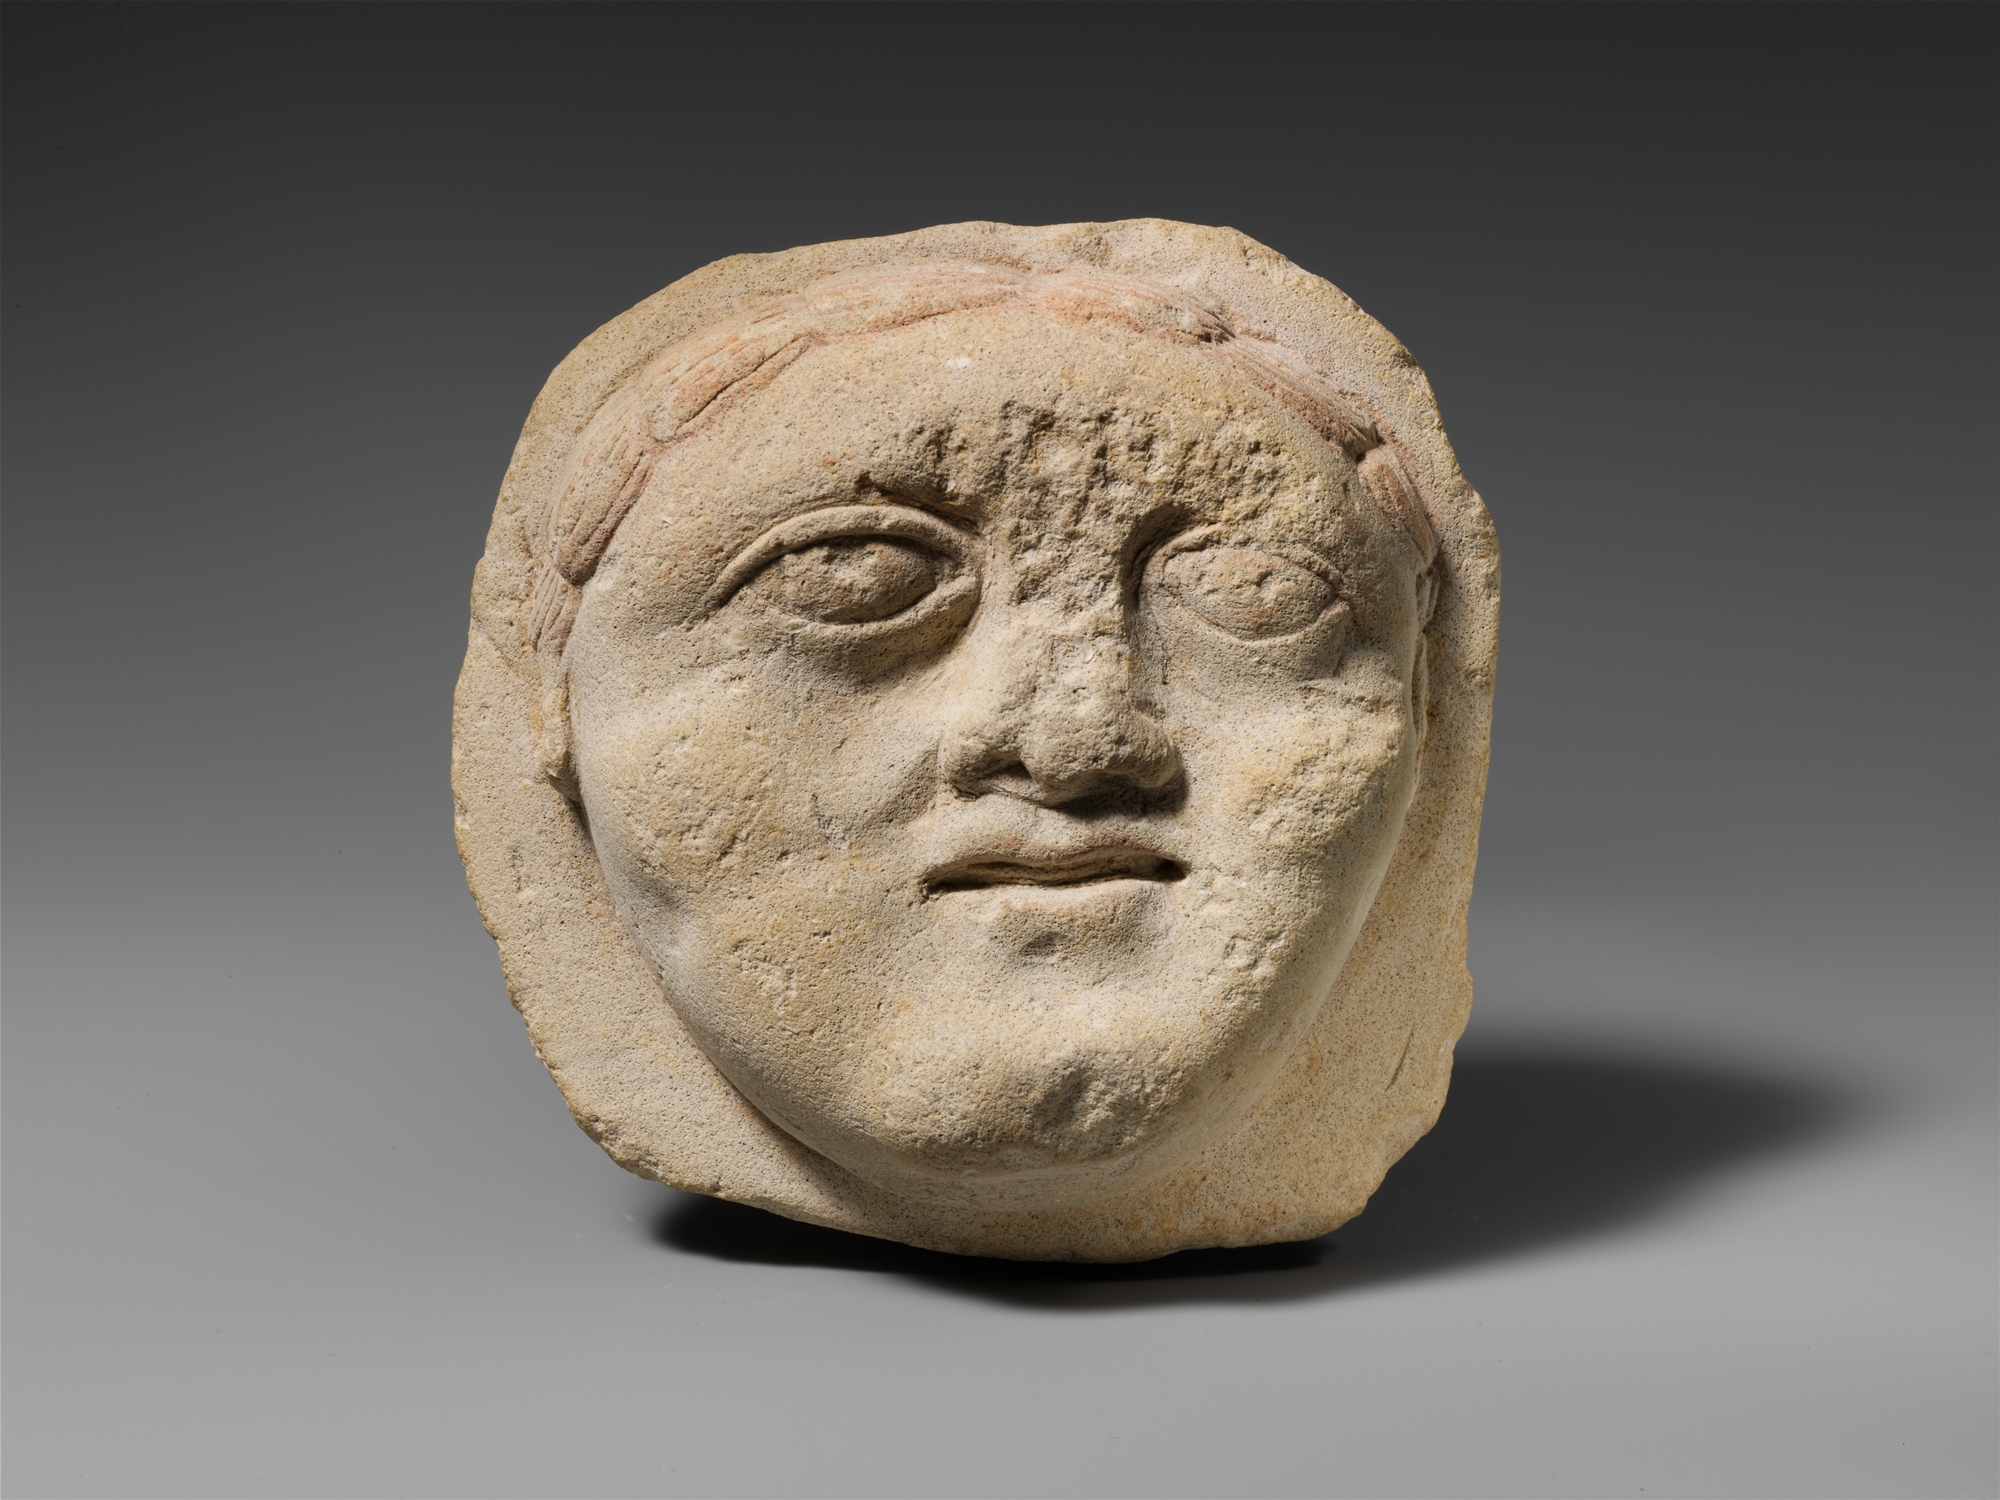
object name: head of medusa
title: Limestone votive head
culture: cypriot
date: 300-1 BCE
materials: limestone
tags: heads